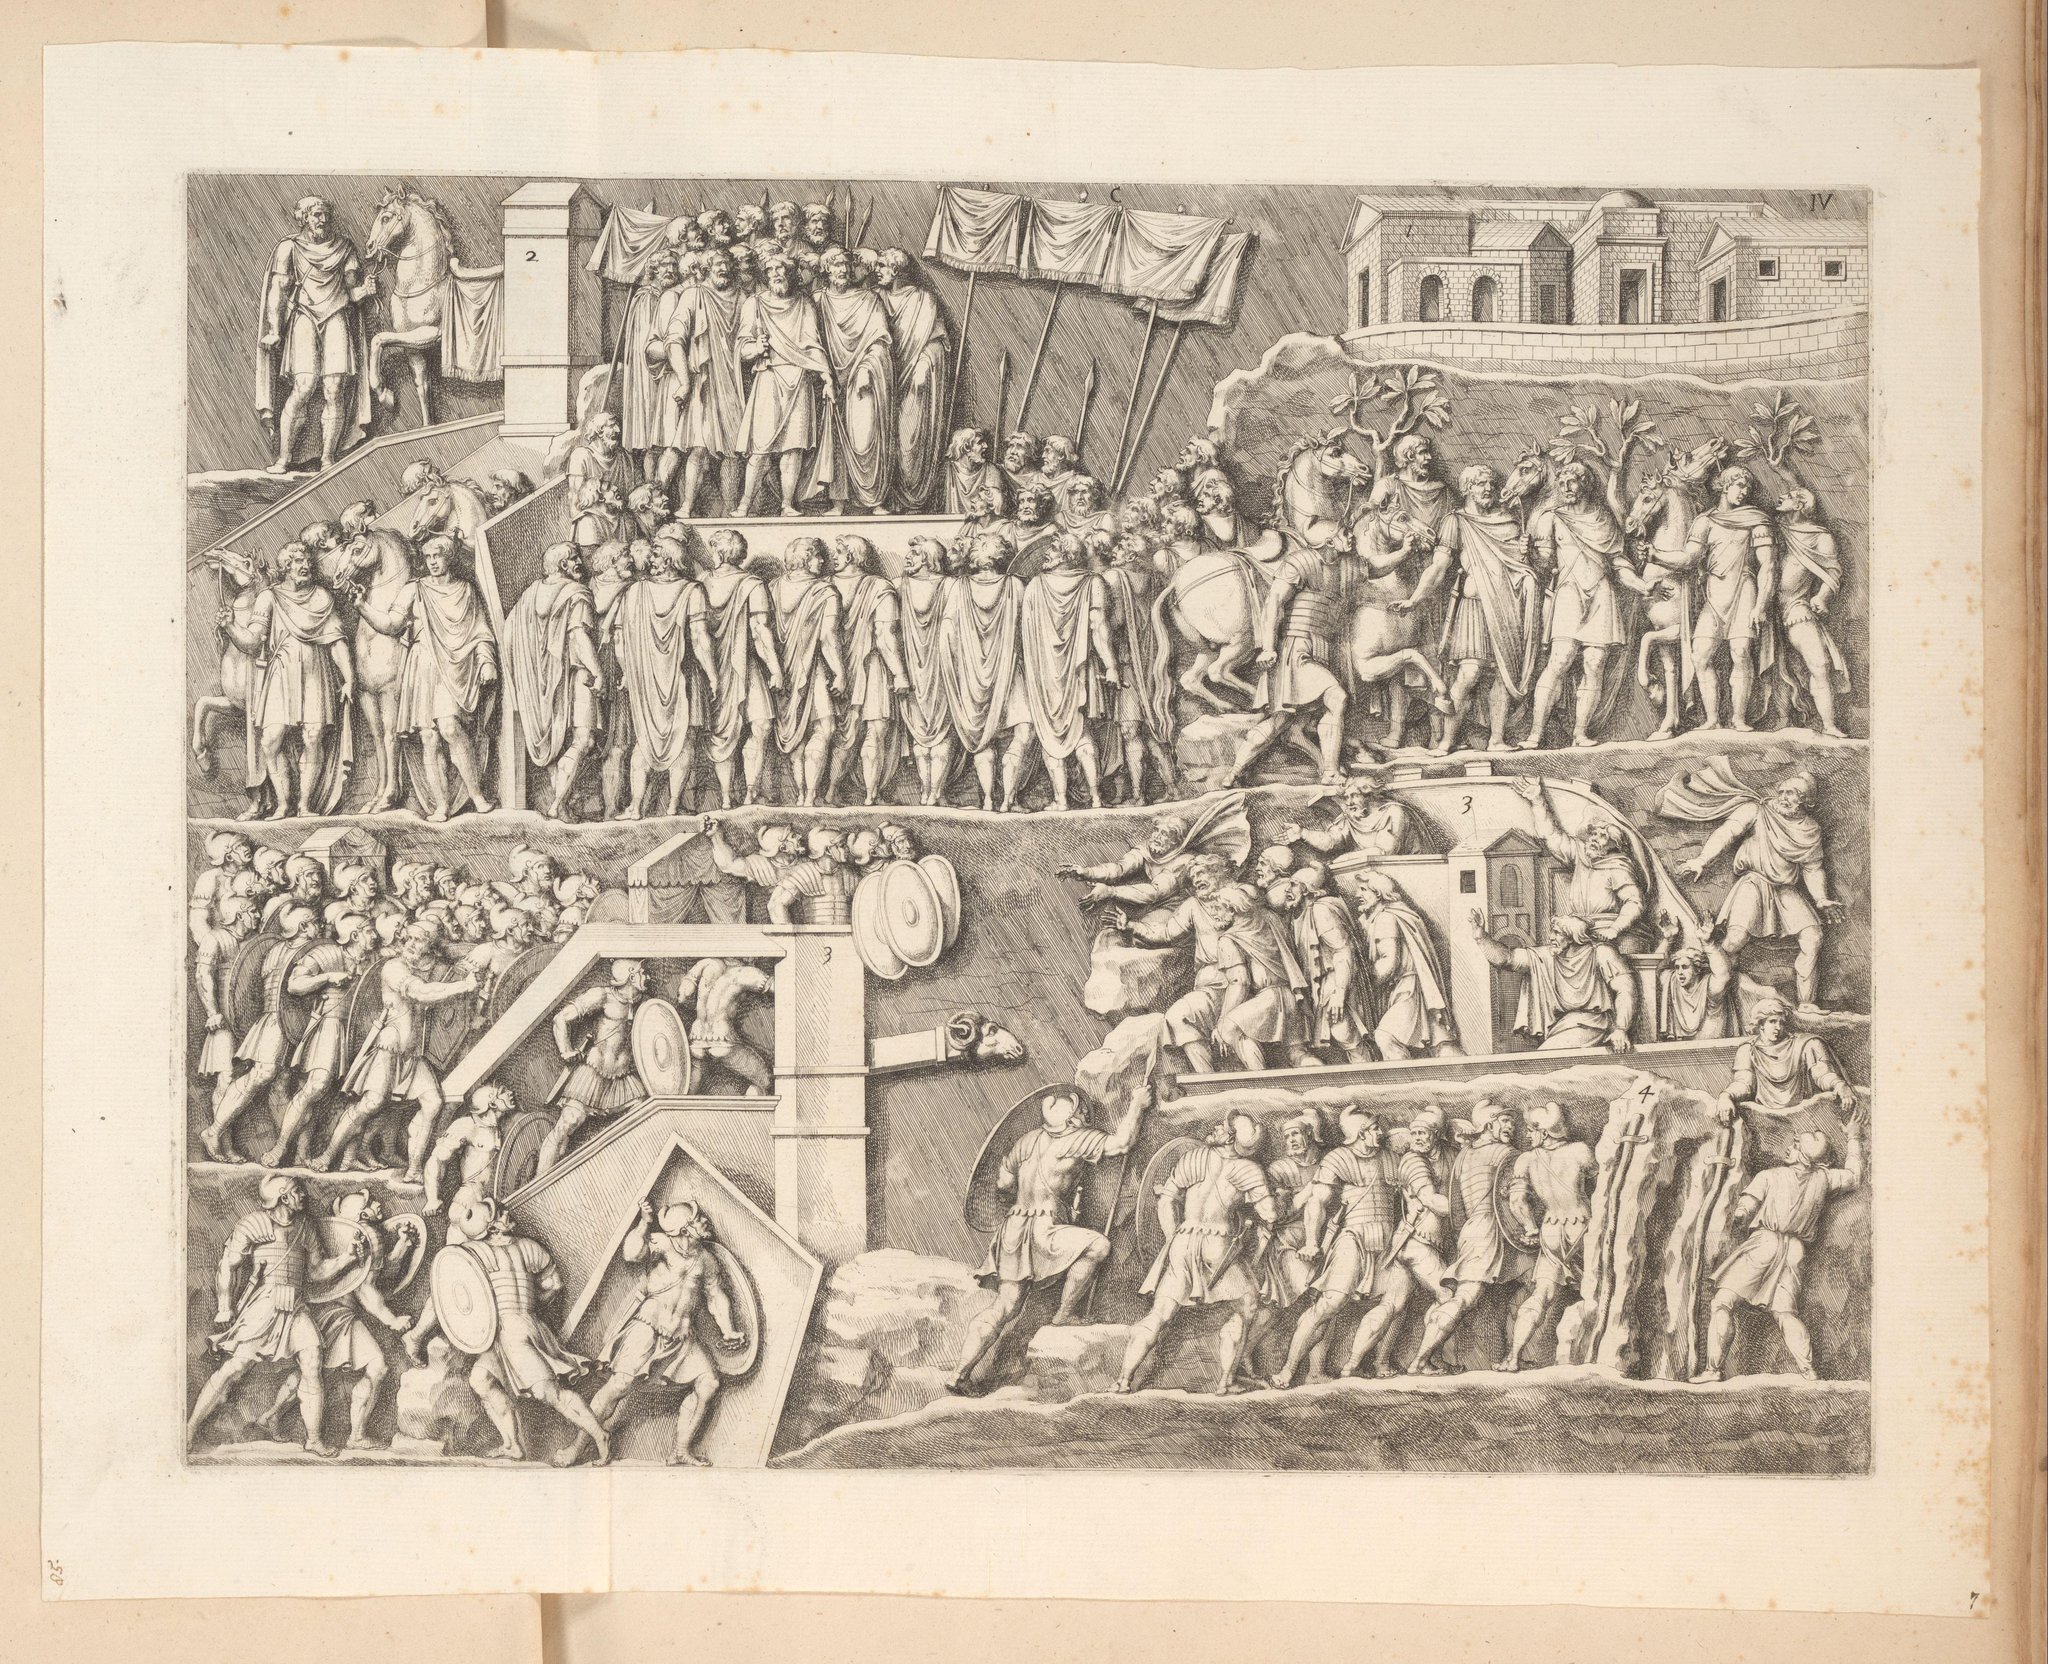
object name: album leaf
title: Reliëfs op de Boog van Septimius Severus te Rome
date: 1676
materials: paper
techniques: etching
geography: italy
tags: triumphal arch, battle, fighting in general, piece of sculpture, reproduction of a piece of sculpture, horse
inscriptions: number: ‘7’, number: ‘39’, number: ‘85’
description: Prent afkomstig uit de publicatie: Suares, Joseph Marie. Arcus L. Septimii Severi Aug. Rome: Michael Hercules, 1676.